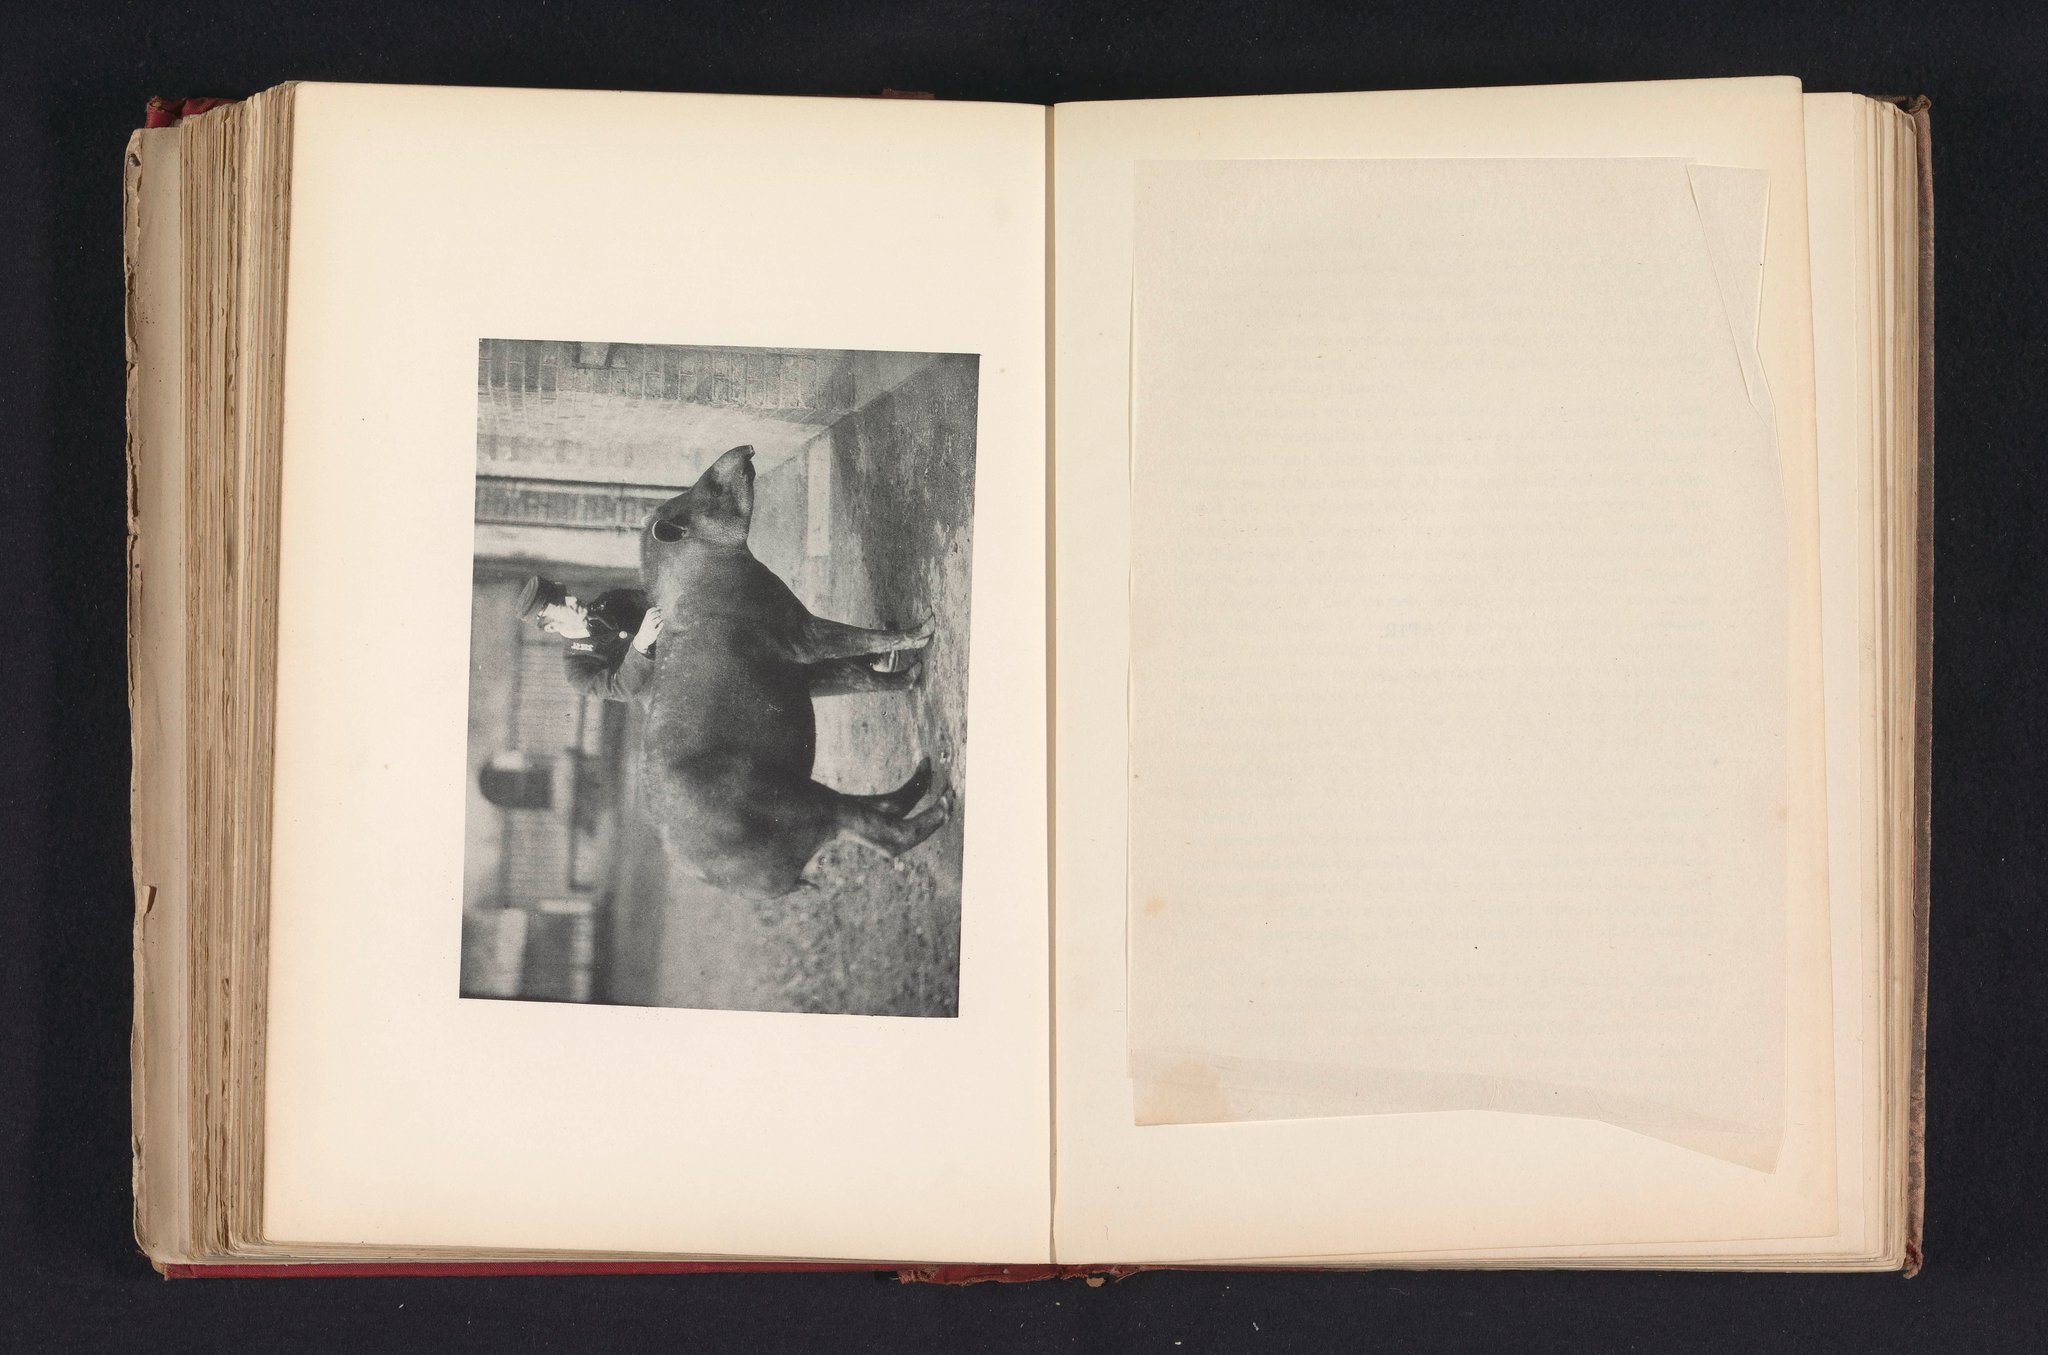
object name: photomechanical print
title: A Tapir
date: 1876-1886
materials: paper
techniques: photograph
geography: paris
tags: zoological garden, zoo, seen as place where non-domestic animals are kept, trunked animals: elephant